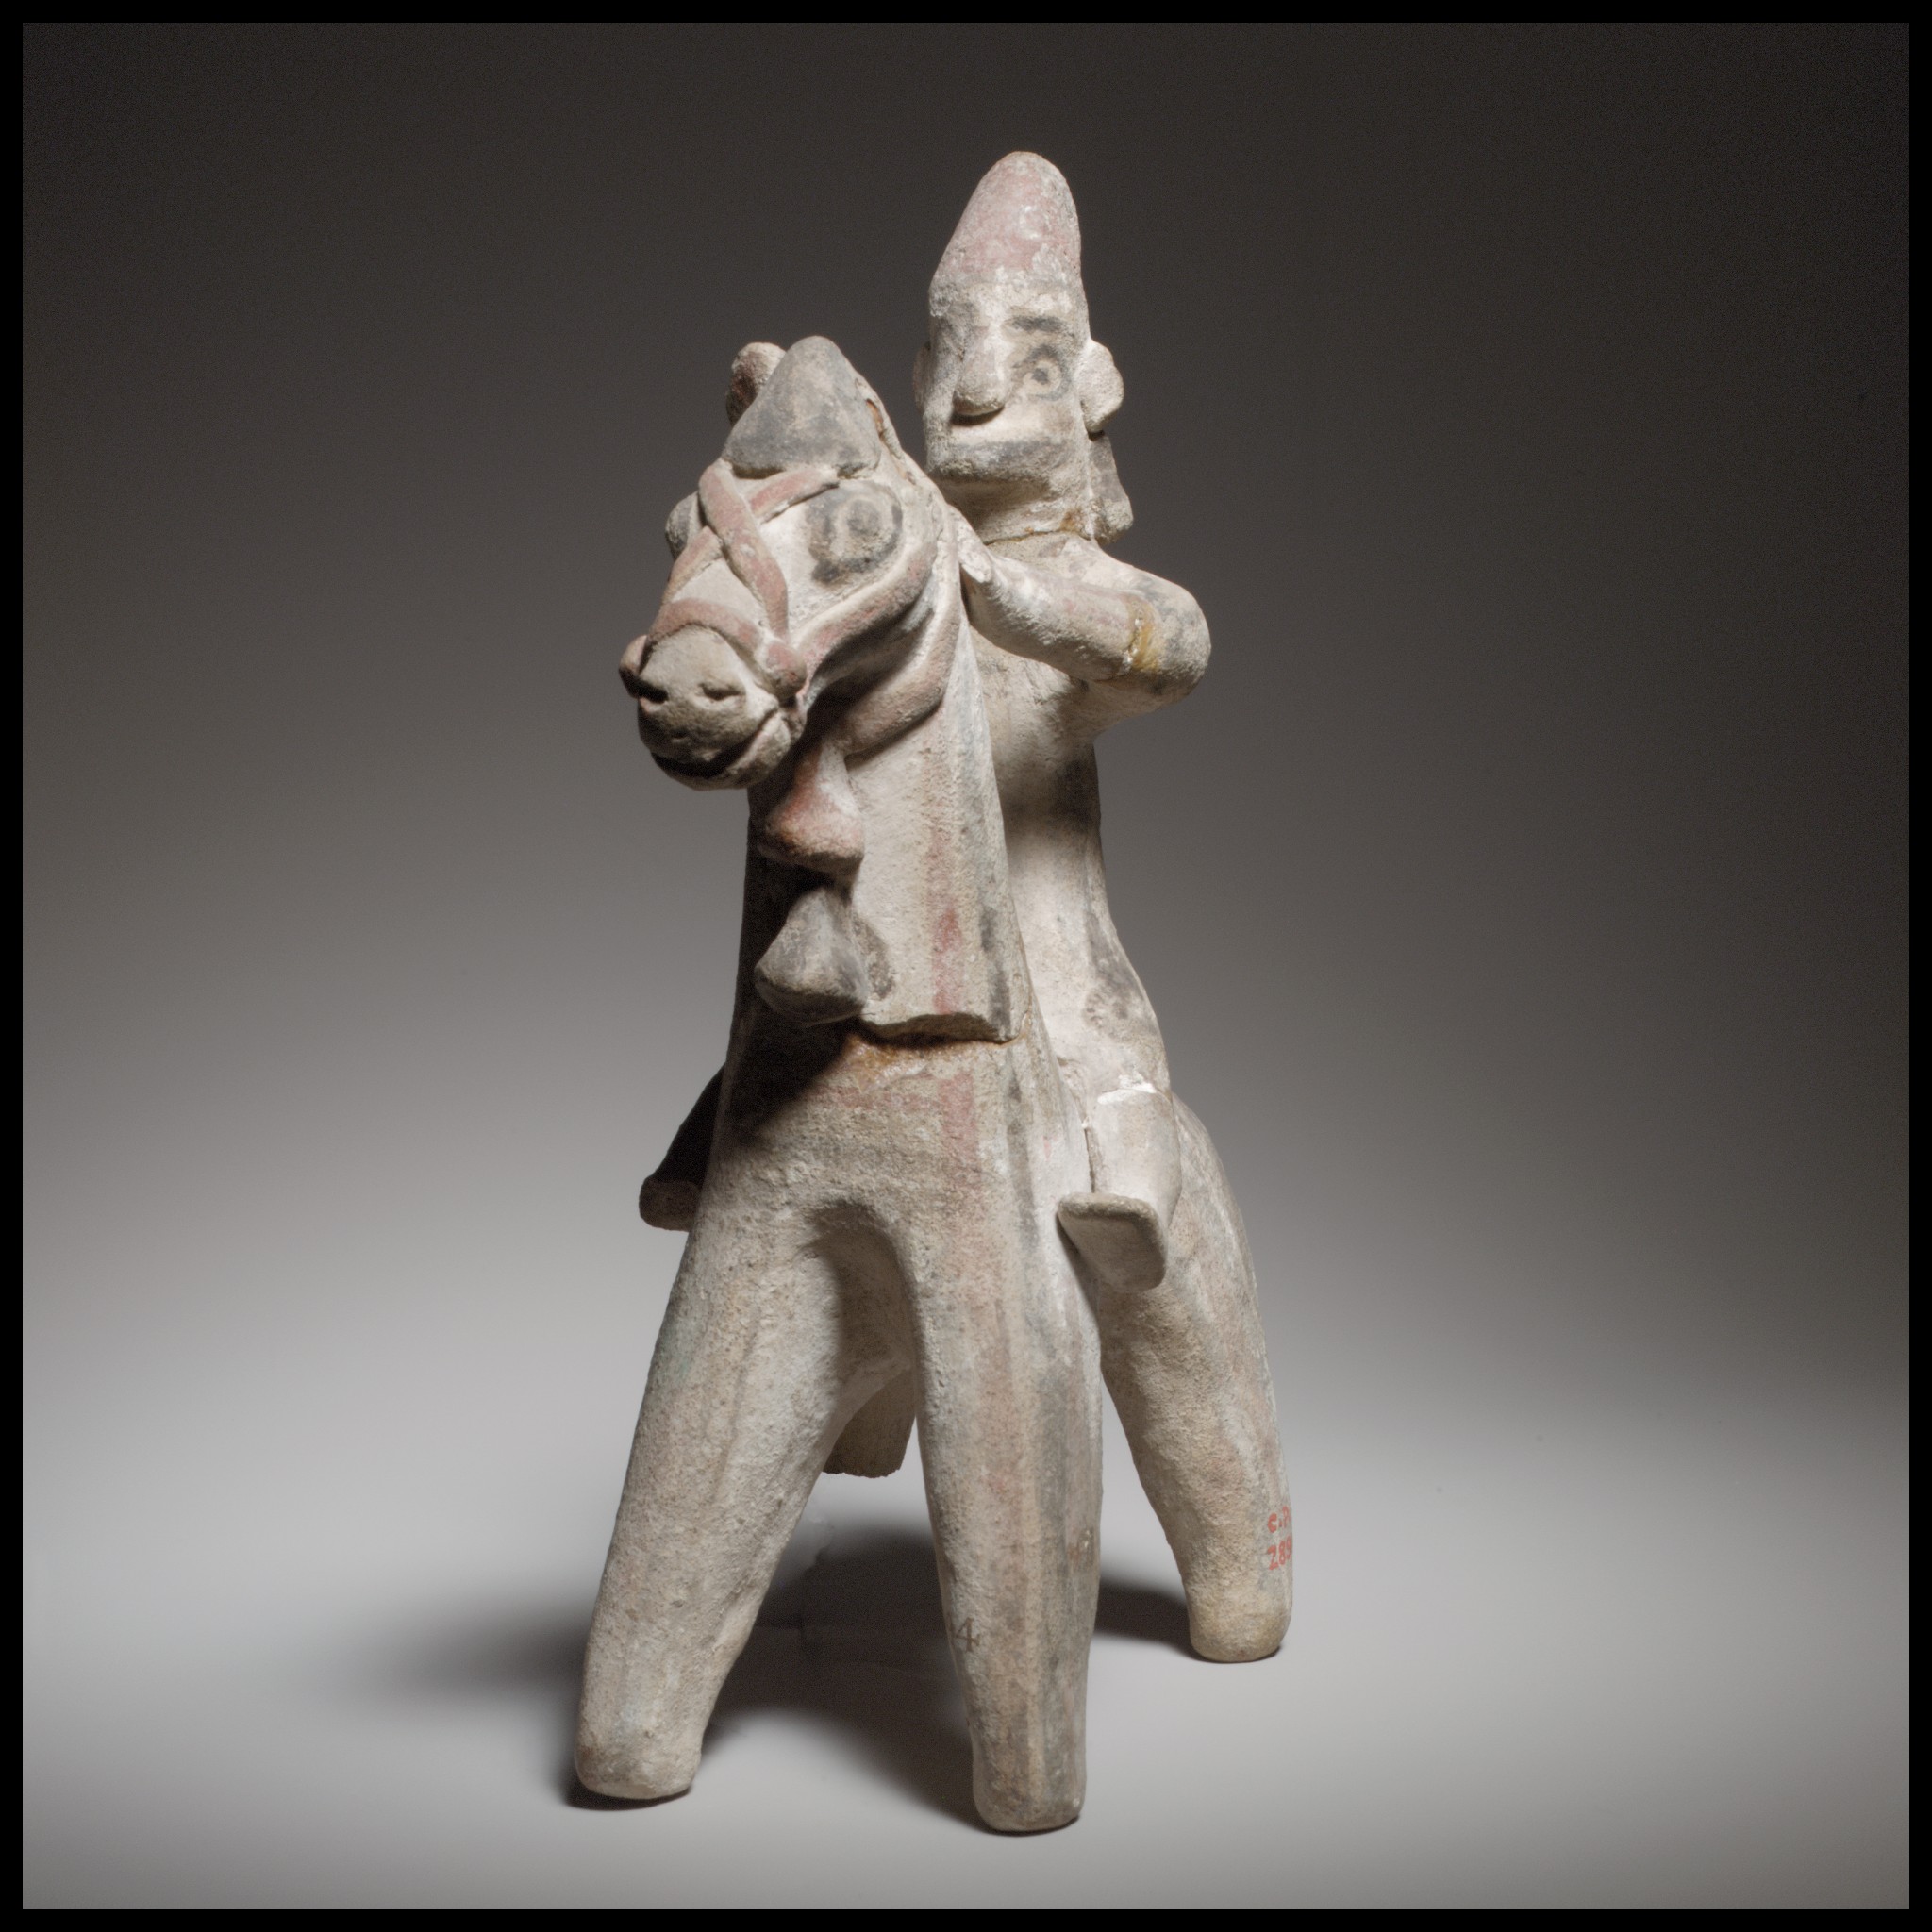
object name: statuette of a horse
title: Horse and rider figurine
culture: cypriot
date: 600-480 BCE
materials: terracotta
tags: human figures,horses